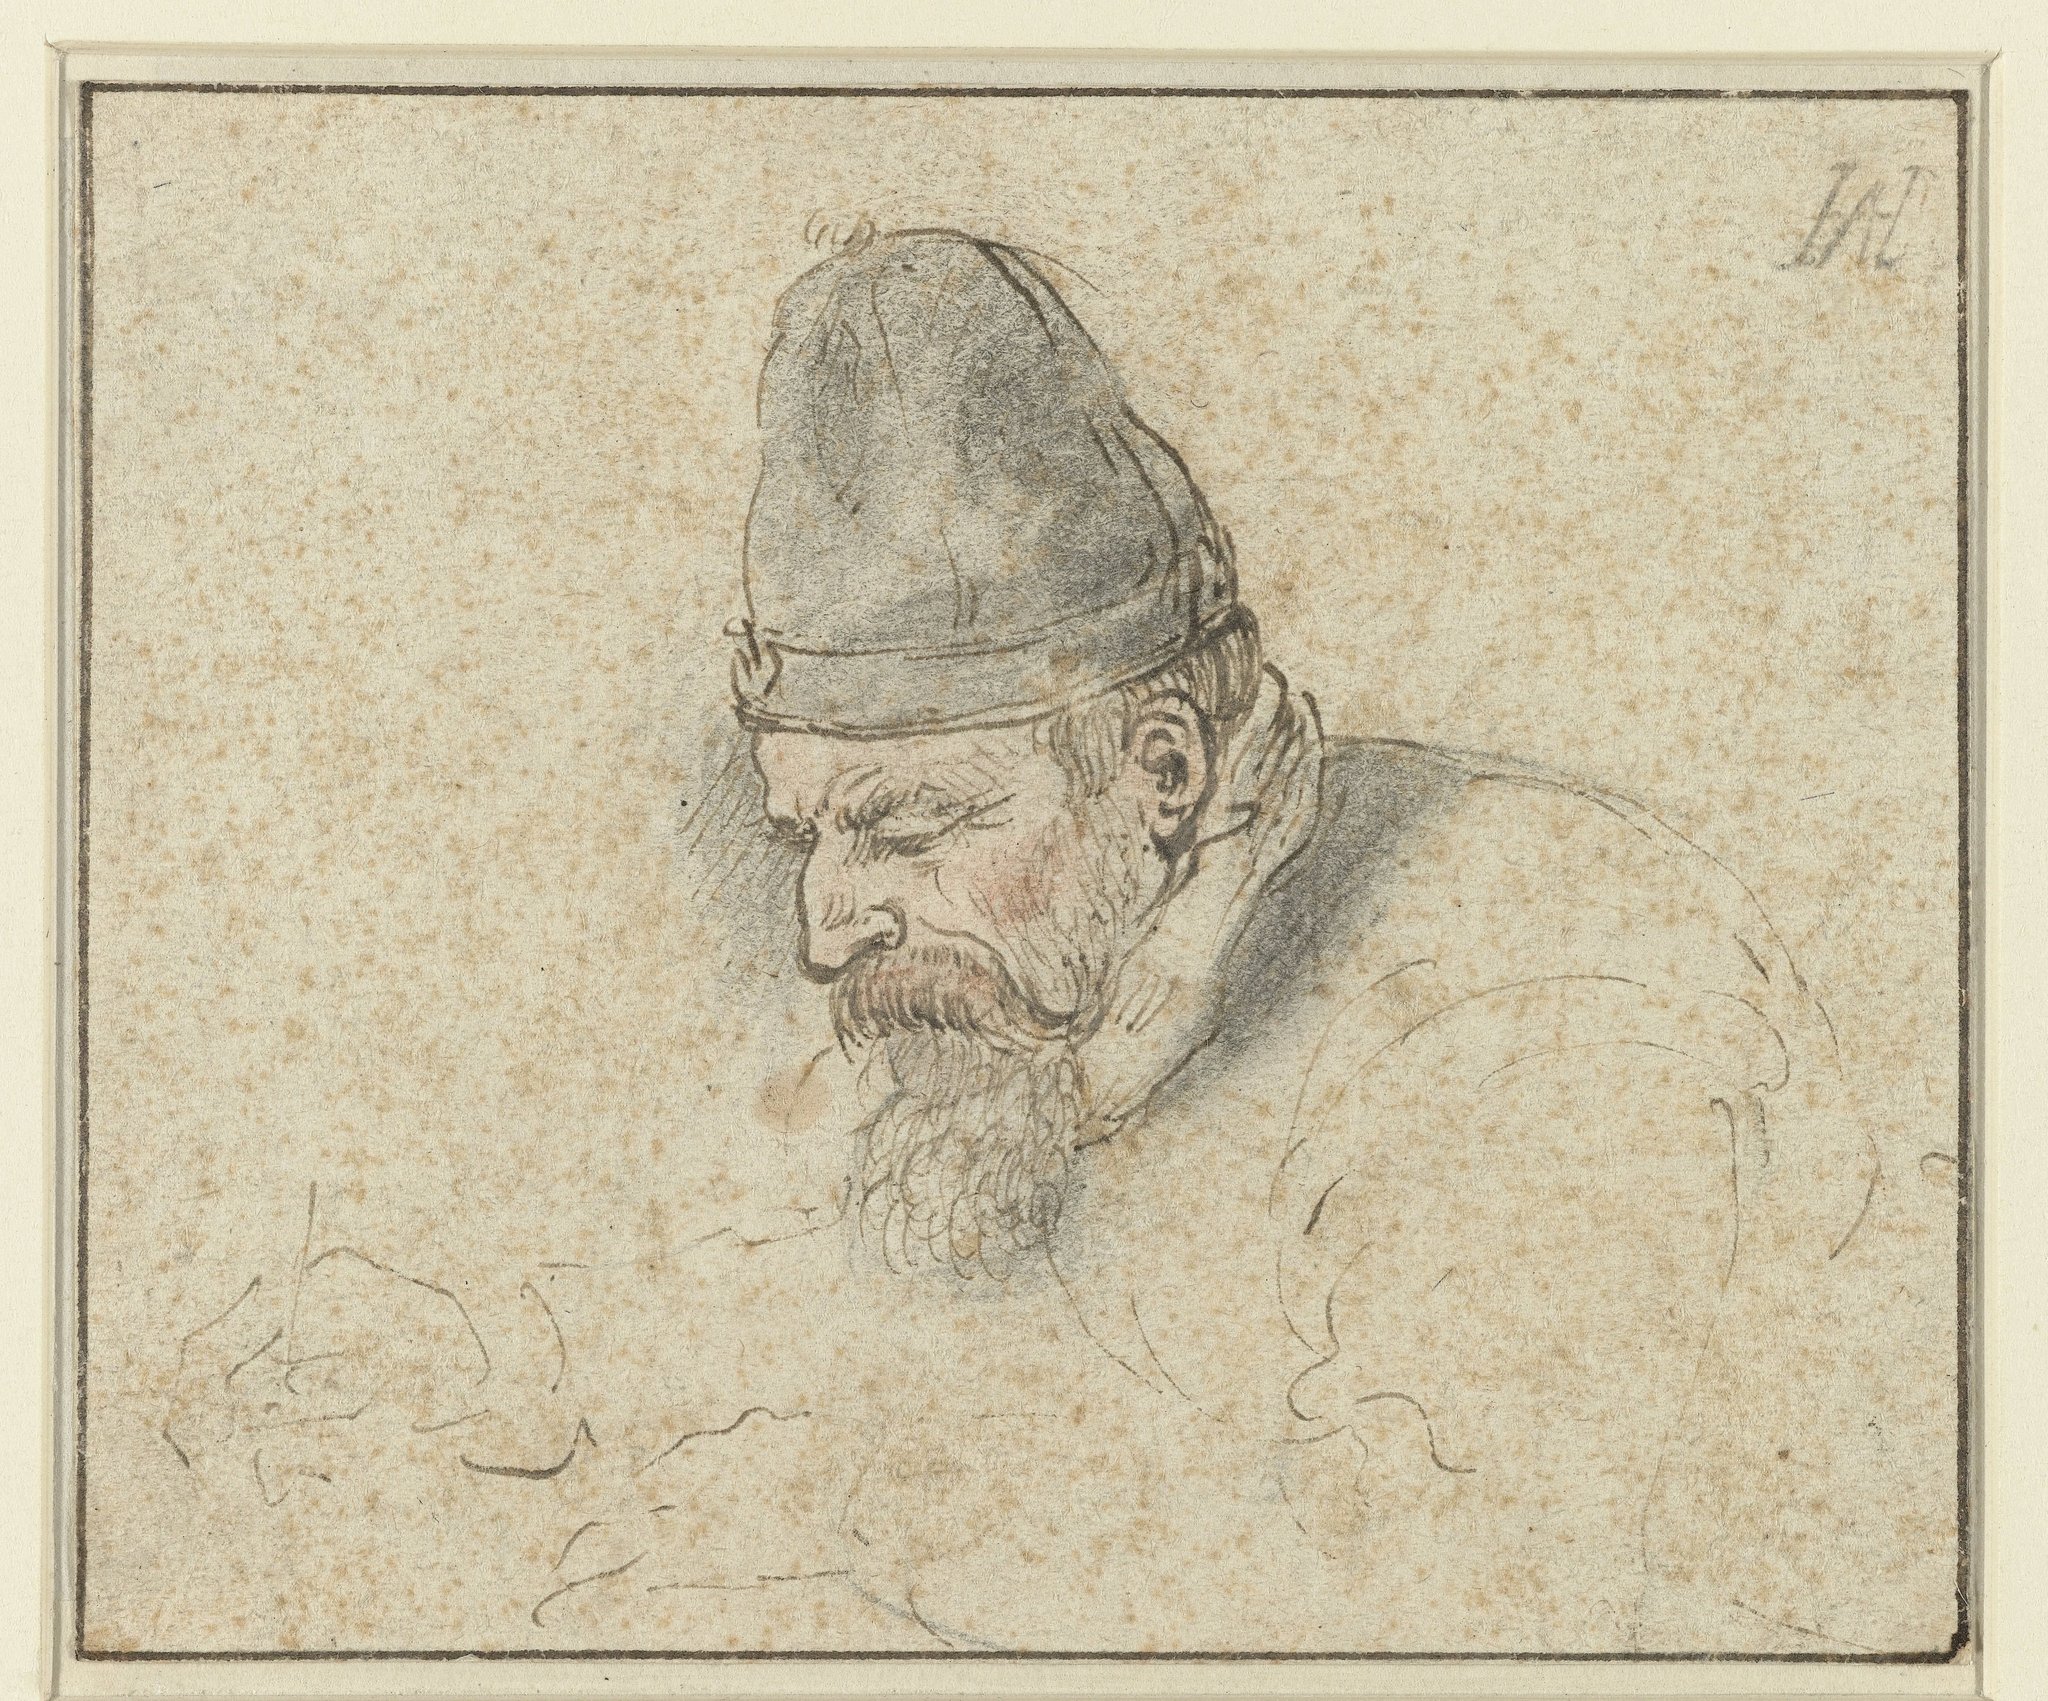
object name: drawing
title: Head of a Man in a Cap, Drawing or Writing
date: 1592-1629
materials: ink, paper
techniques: pen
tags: amsterdam, hendrick avercamp, deaf, deafness, historical persons, portrait, self-portrait of painter, portrait, self-portrait of artist, portrait, self-portrait of draughtsman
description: Portret van Hendrick Avercamp, die ook bekend stond als ‘de Stomme van Kampen’ waarschijnlijk omdat hij door zijn doofheid niet verbaal communiceerde. (Portret van Gerard ter Borch I ?)